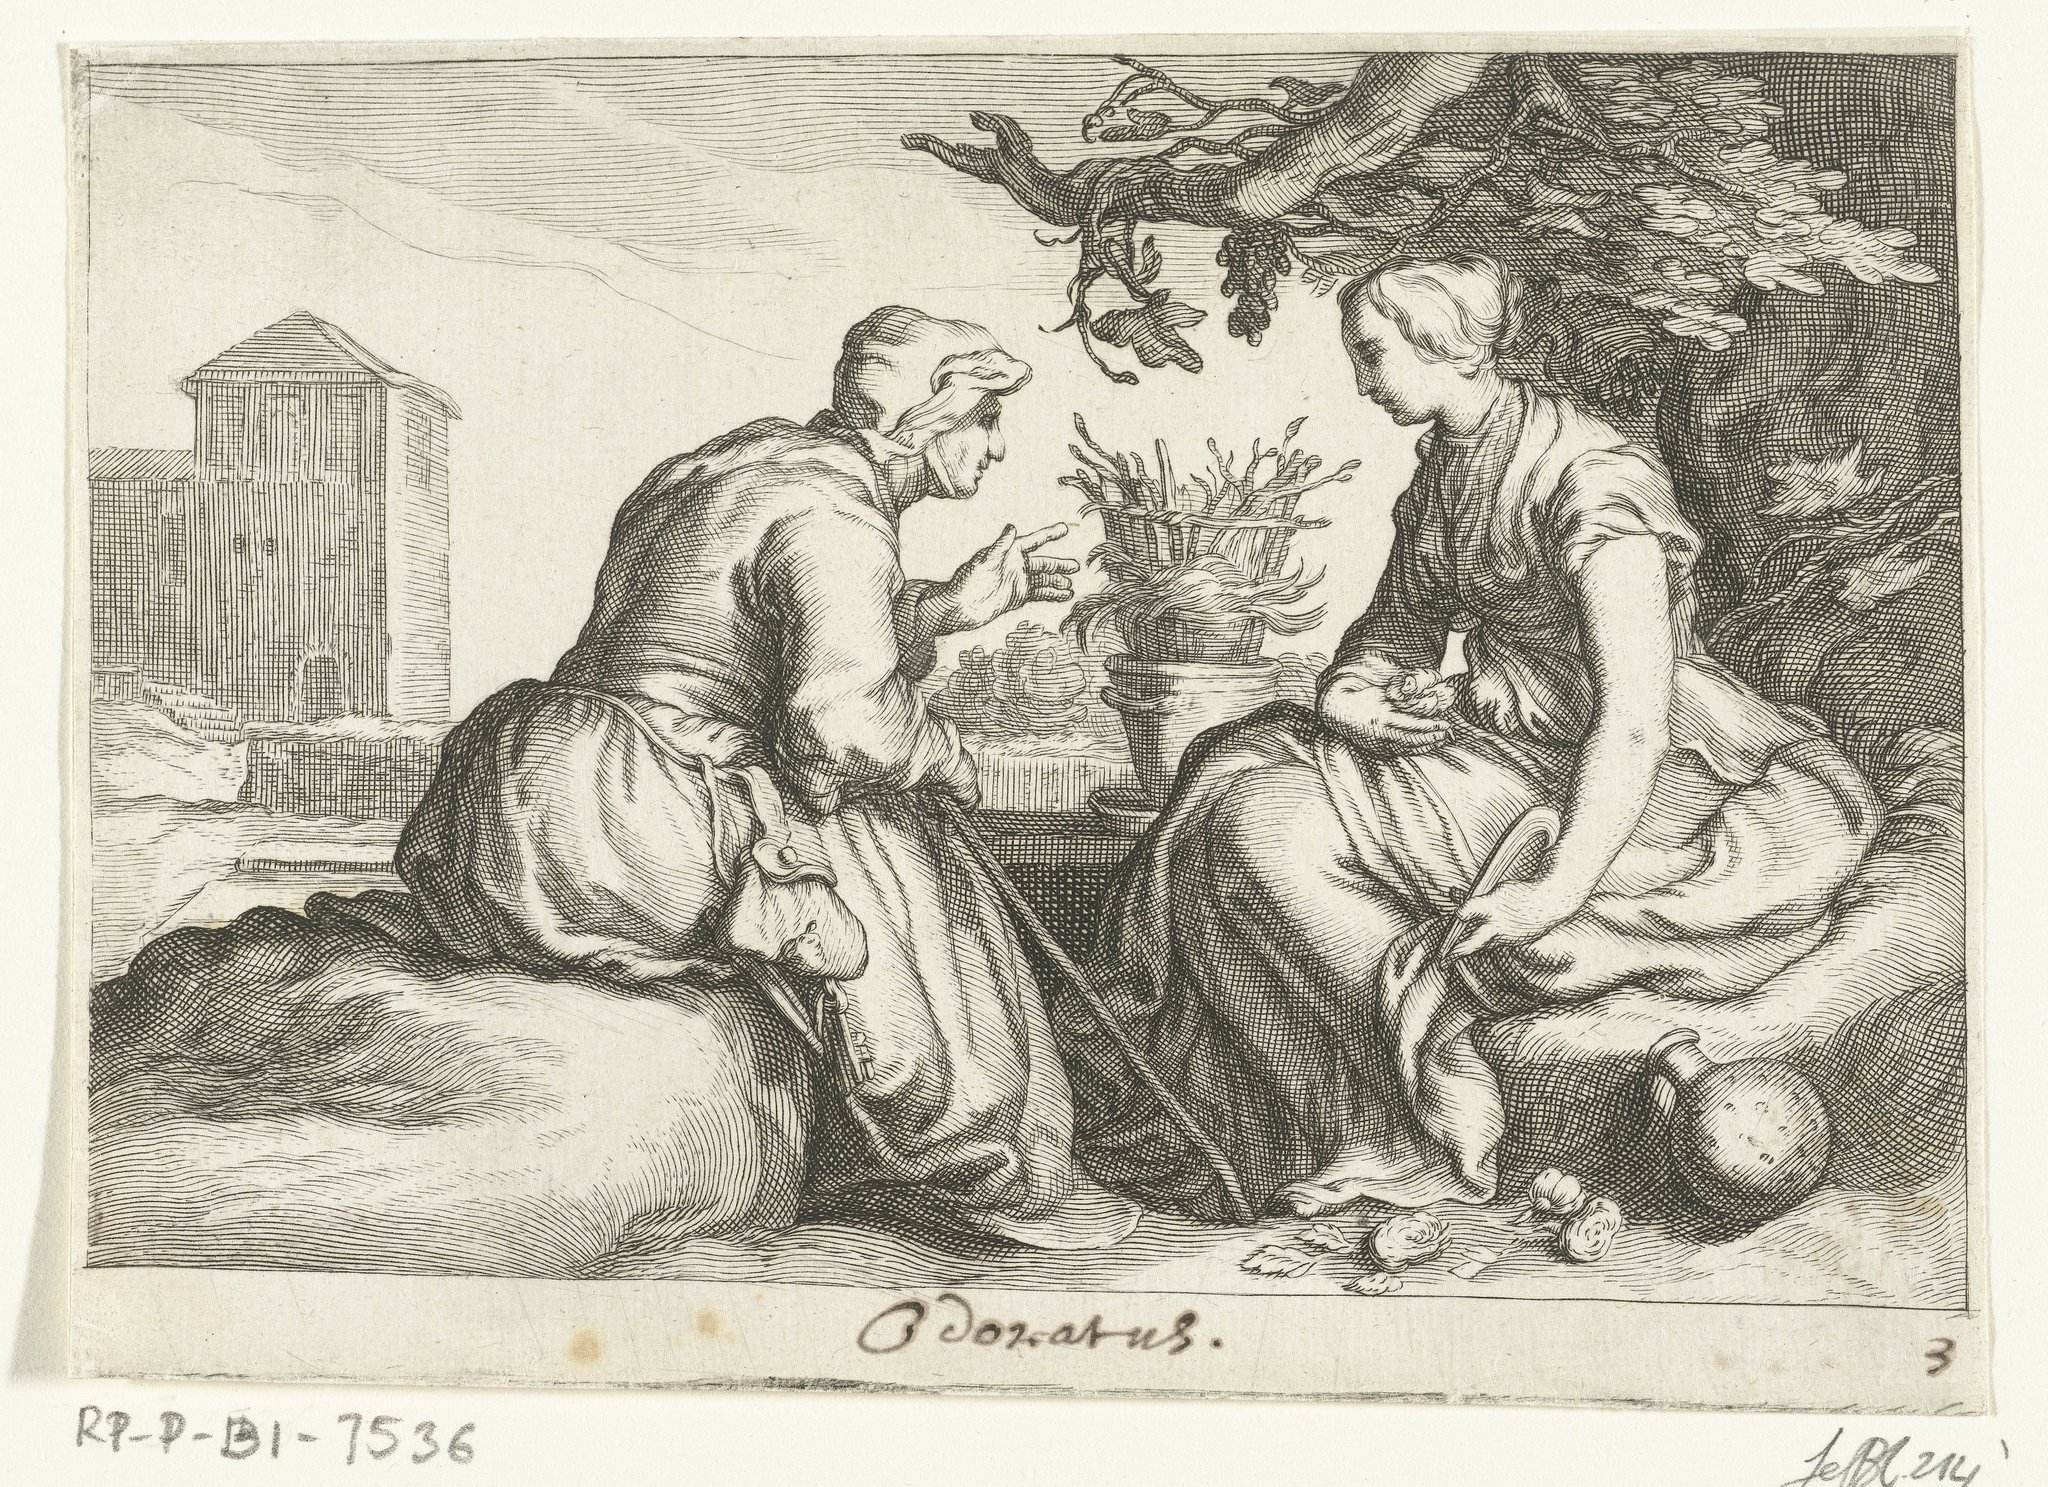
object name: print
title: Vijf zintuigen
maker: frederick bloemaert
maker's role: print maker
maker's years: 1614-1669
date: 1632-1670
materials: paper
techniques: engraving, etching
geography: utrecht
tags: vertumnus and pomona, smell, smelling (one of the five senses)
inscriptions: collector's mark: Lugt 240, inscription: ‘Odoratus’, number: ‘3’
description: Vertumnus zit, in de gestalte van een oude vrouw, tegenover Pomona. Met haar snoeimes heeft Pomona de bloemen van een bos anjers afgesneden. Een bloem houdt ze in haar hand, de andere liggen op de grond. Voorstelling van de Reuk, uit een serie met vijf prenten die de zintuigen afbeelden.